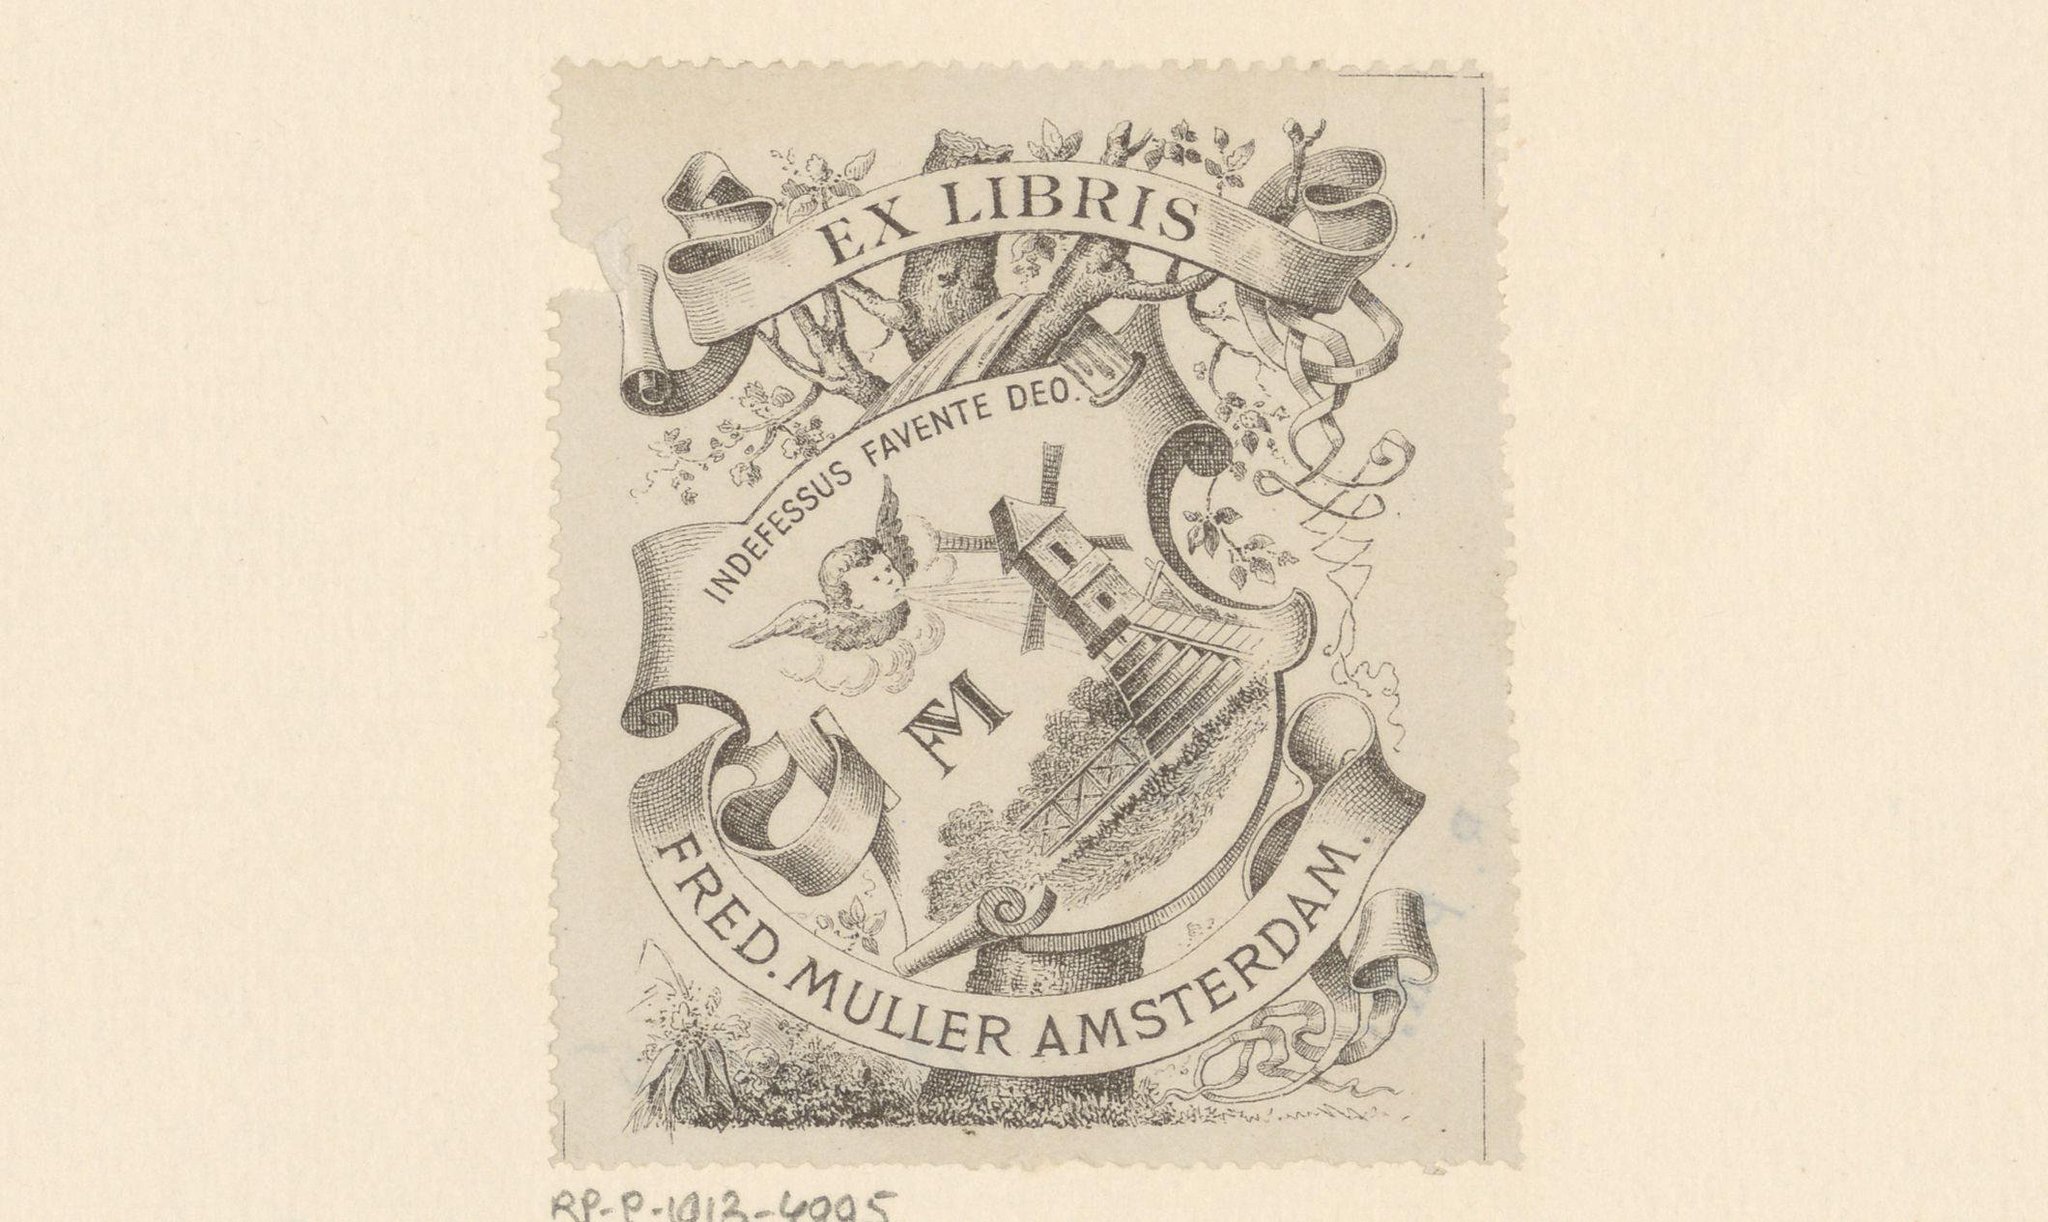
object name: bookplate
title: Indefessus favente Deo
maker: Anonymous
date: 1827-1881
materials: paper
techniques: printing block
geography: netherlands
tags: amsterdam, bookseller, frederik muller, trees, winds, windmill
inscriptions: collector's mark: Lugt 2760, collector's mark: Lugt 2233